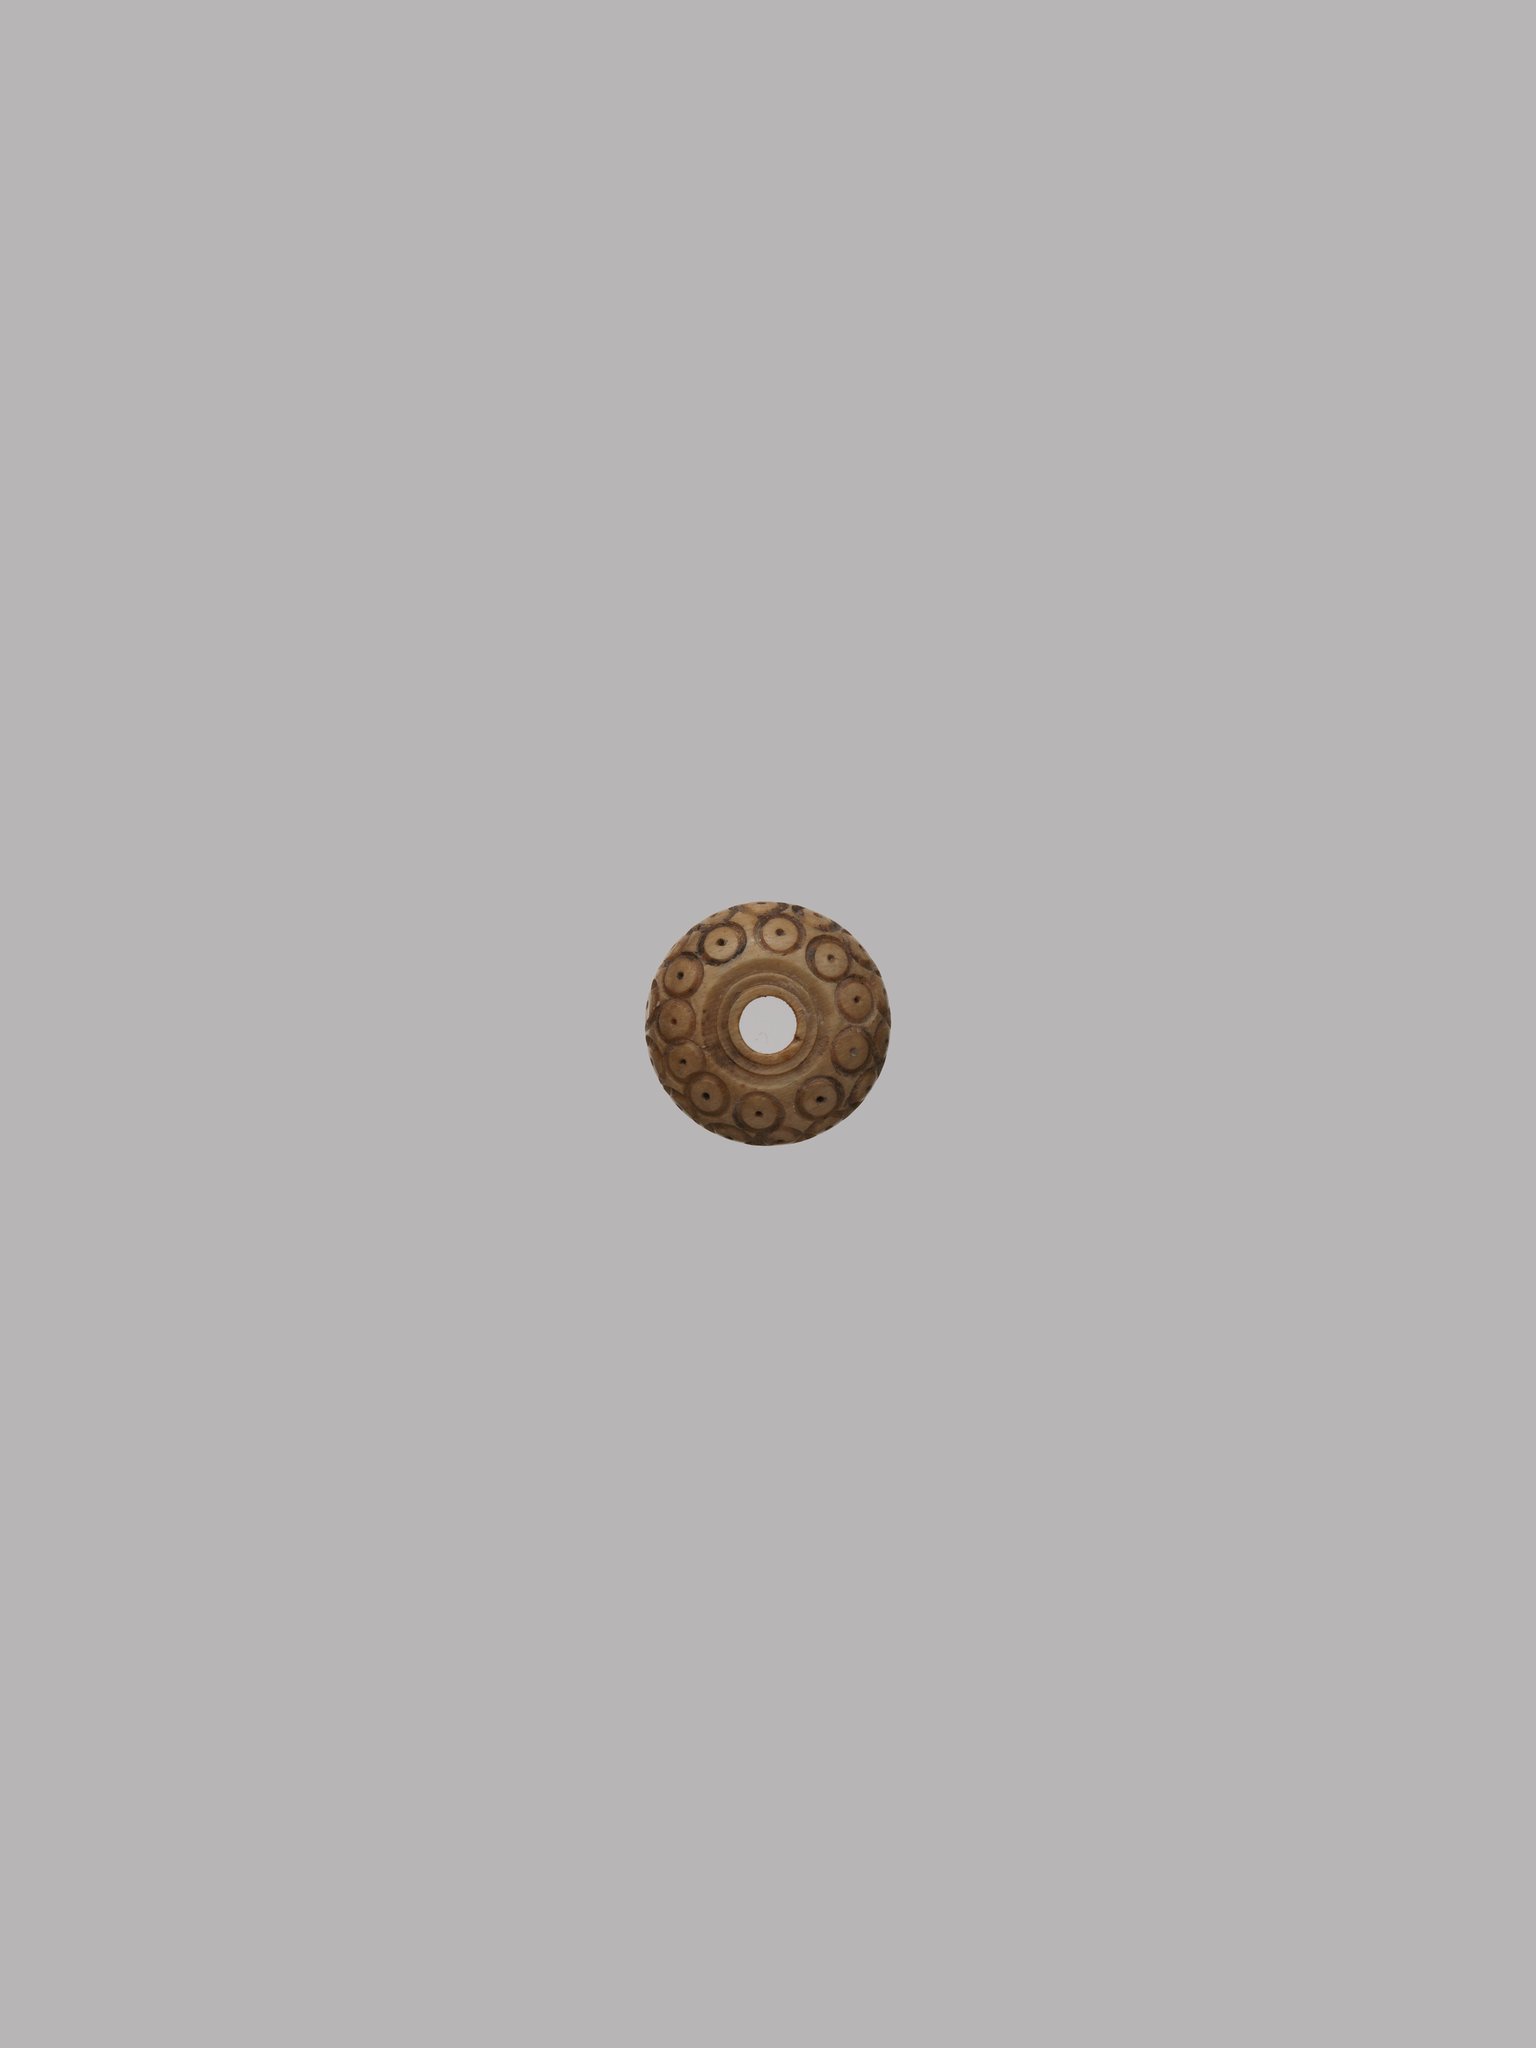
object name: button or bead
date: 801-1000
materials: bone, paint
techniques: incising, inlay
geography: iran